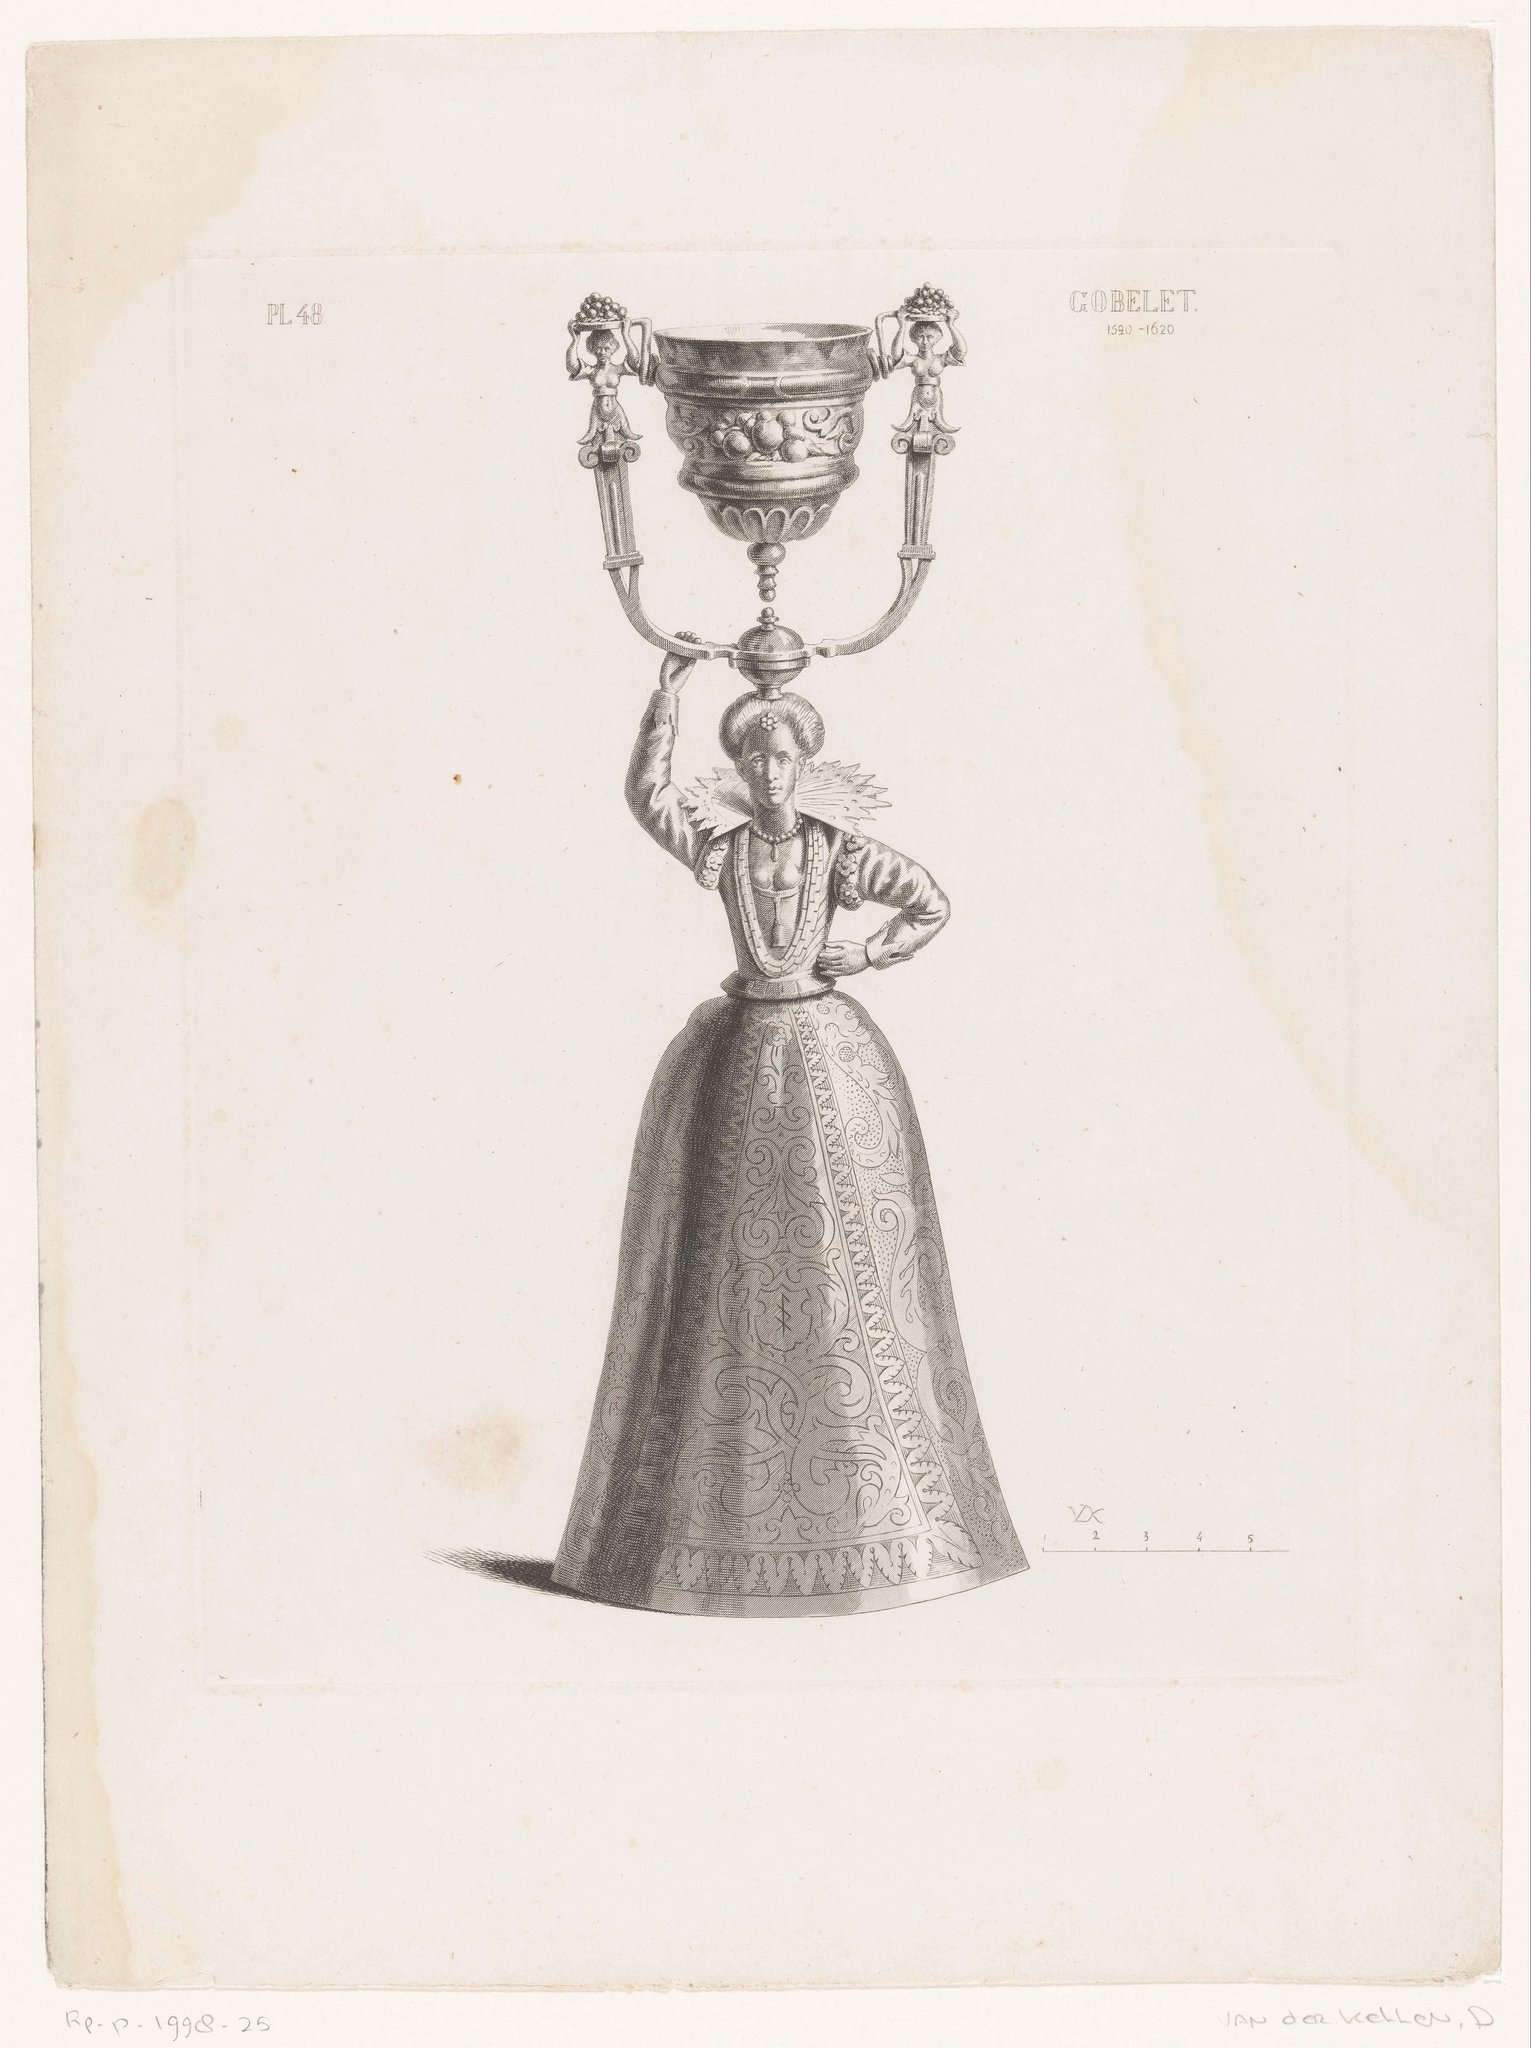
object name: print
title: Gobelet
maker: david van der kellen (1804-1879)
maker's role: die cutter, draughtsman, print maker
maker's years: 1804-1879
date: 1865-1878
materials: paper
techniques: etching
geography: netherlands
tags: mug, beaker, goblet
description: Een zestiende-eeuwse zilveren gobelet in de vorm van een vrouwenfiguur.